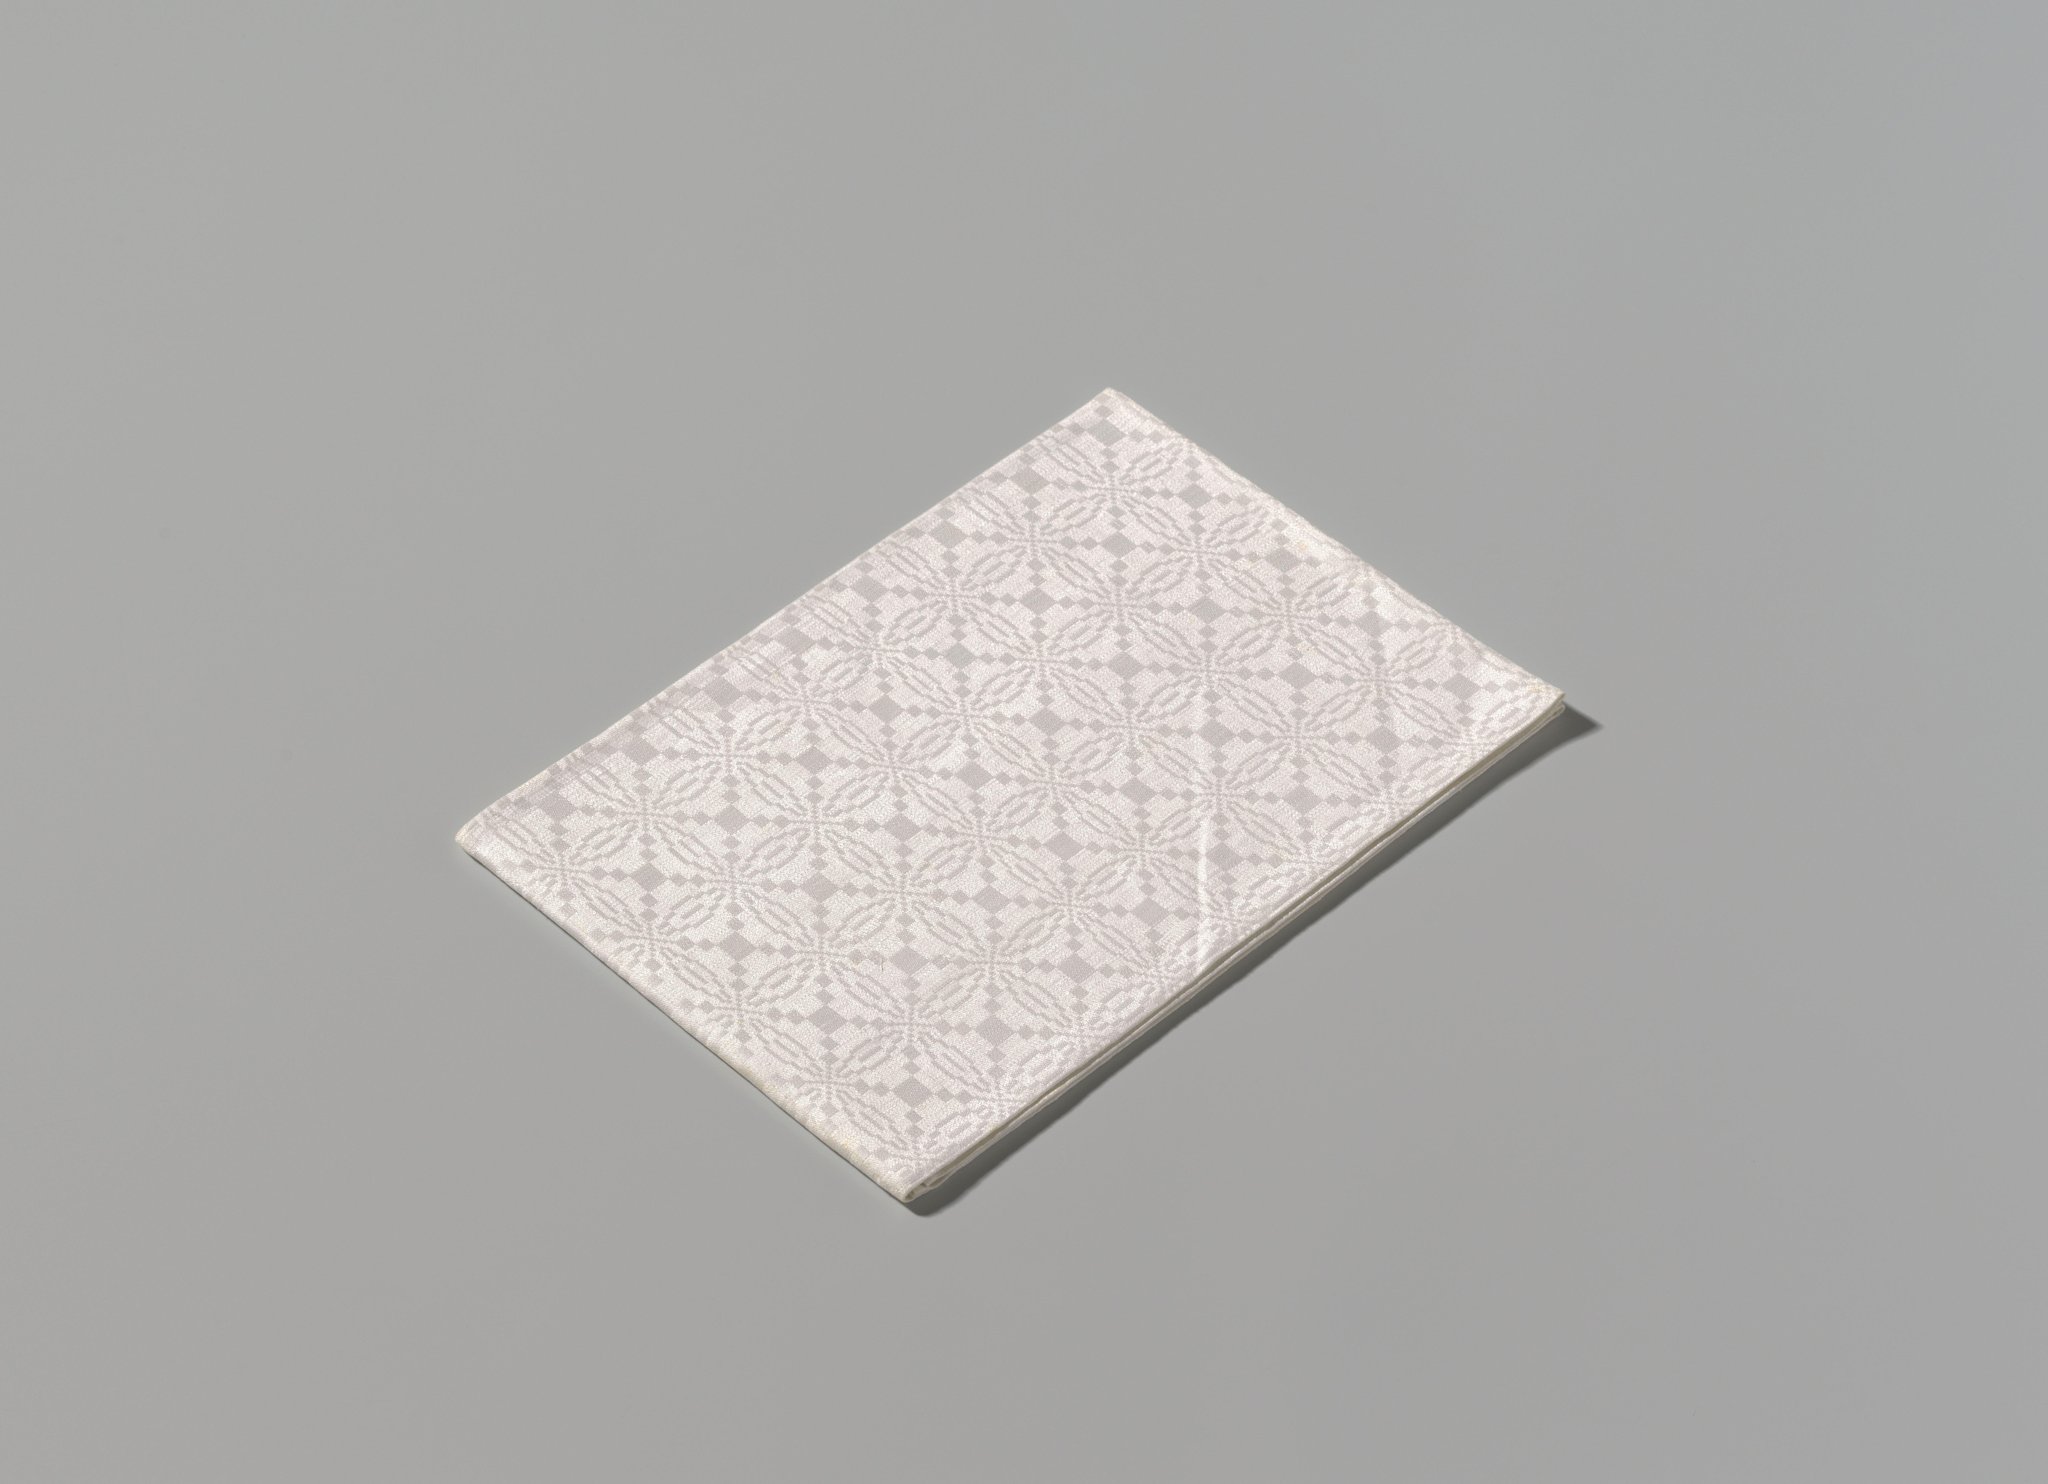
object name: napkin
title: Servet van linnen met pellenpatroon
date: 1620-1660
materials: linen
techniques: peeled fabric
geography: northern netherlands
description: Wit linnen servet met een pellen patroon. Merk AVR HB.